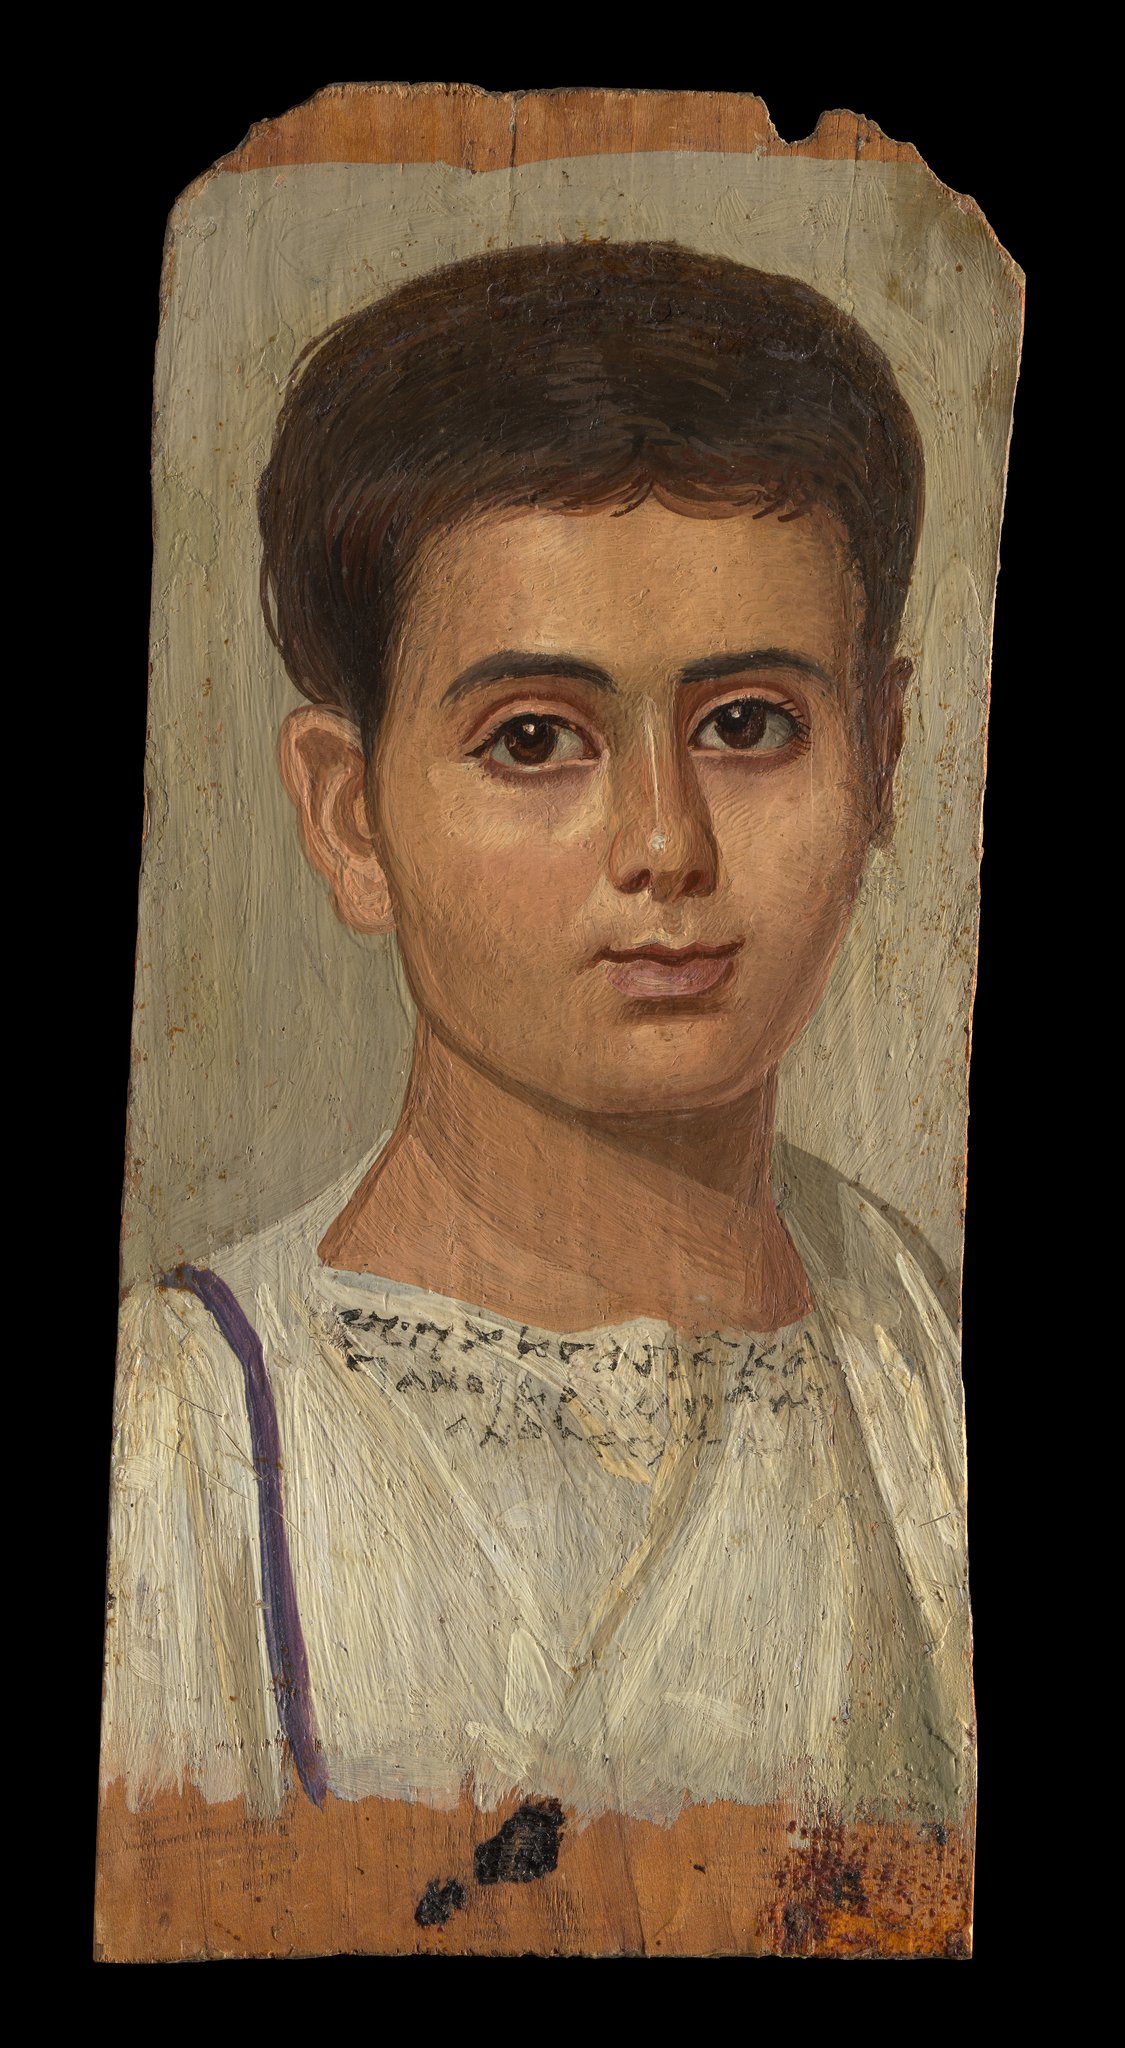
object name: panel painting, eutyches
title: Portrait of the Boy Eutyches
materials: wood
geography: egypt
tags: boys,portraits